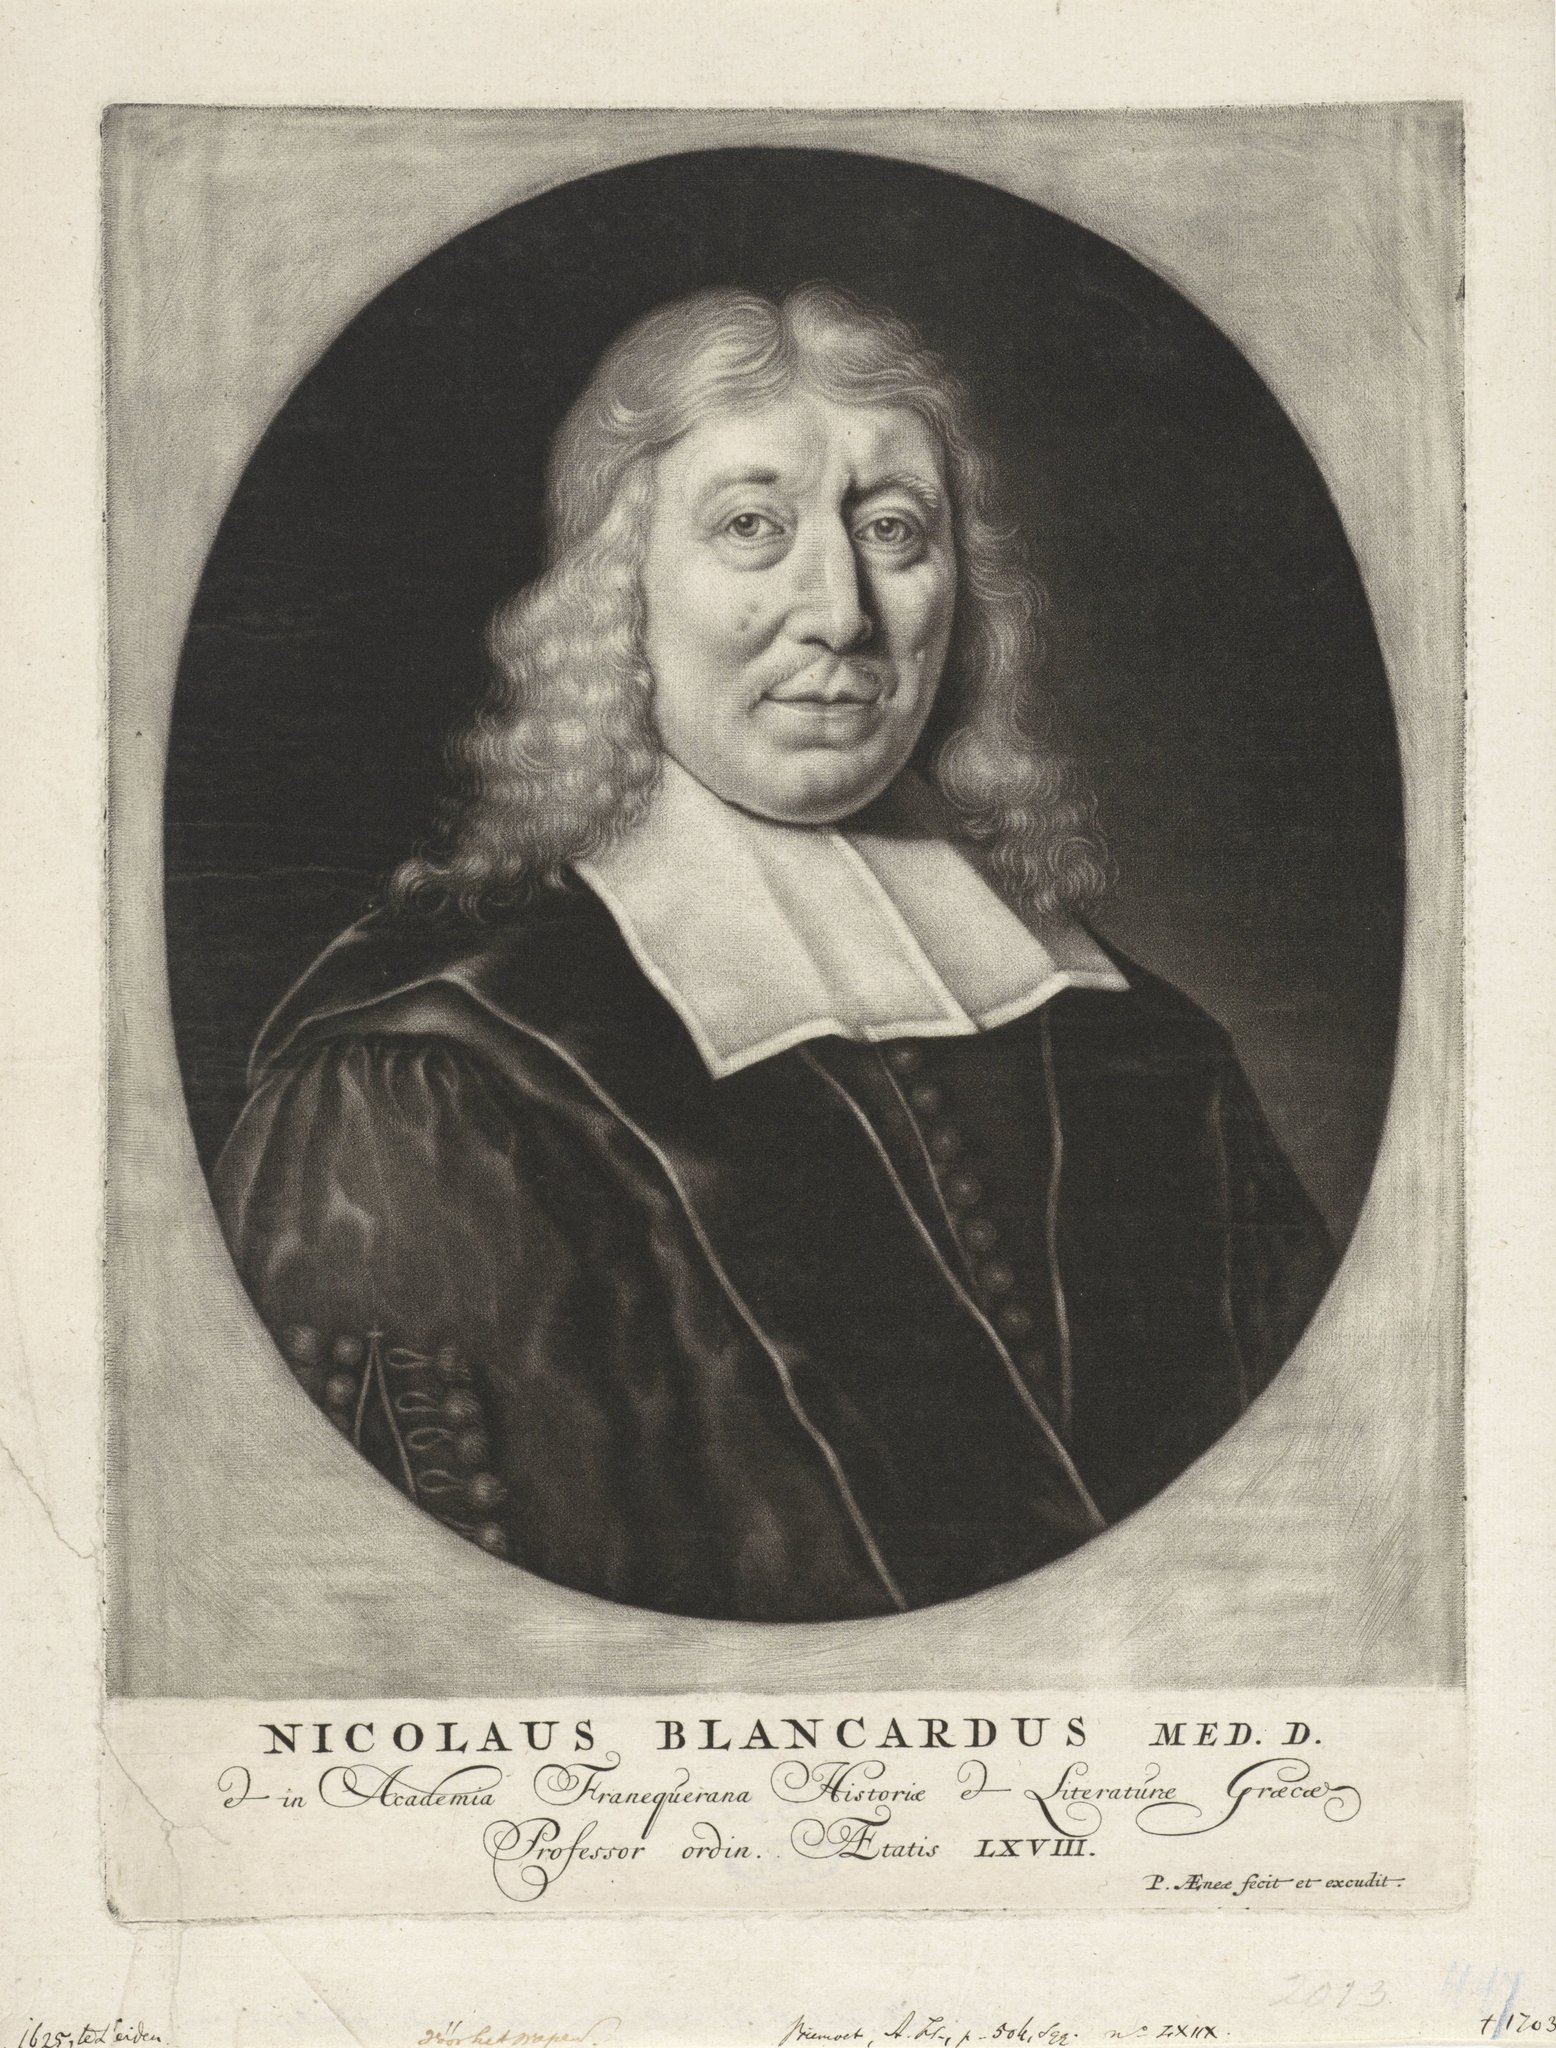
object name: print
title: Portret van Nicolaas Blanckaert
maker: petrus aeneae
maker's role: painter, print maker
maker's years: 1650-1727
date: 1692-1700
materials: paper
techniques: engraving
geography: franeker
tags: leiden, nicolaas blanckaert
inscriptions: collector's mark: Lugt 2228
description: Portret van Nicolaas Blanckaert op 68-jarige leeftijd. Hij was hoogleraar te Franeker, geheimraad en lijfarts van prinses Albertina Agnes. In de marge zijn naam, titels en leeftijd.